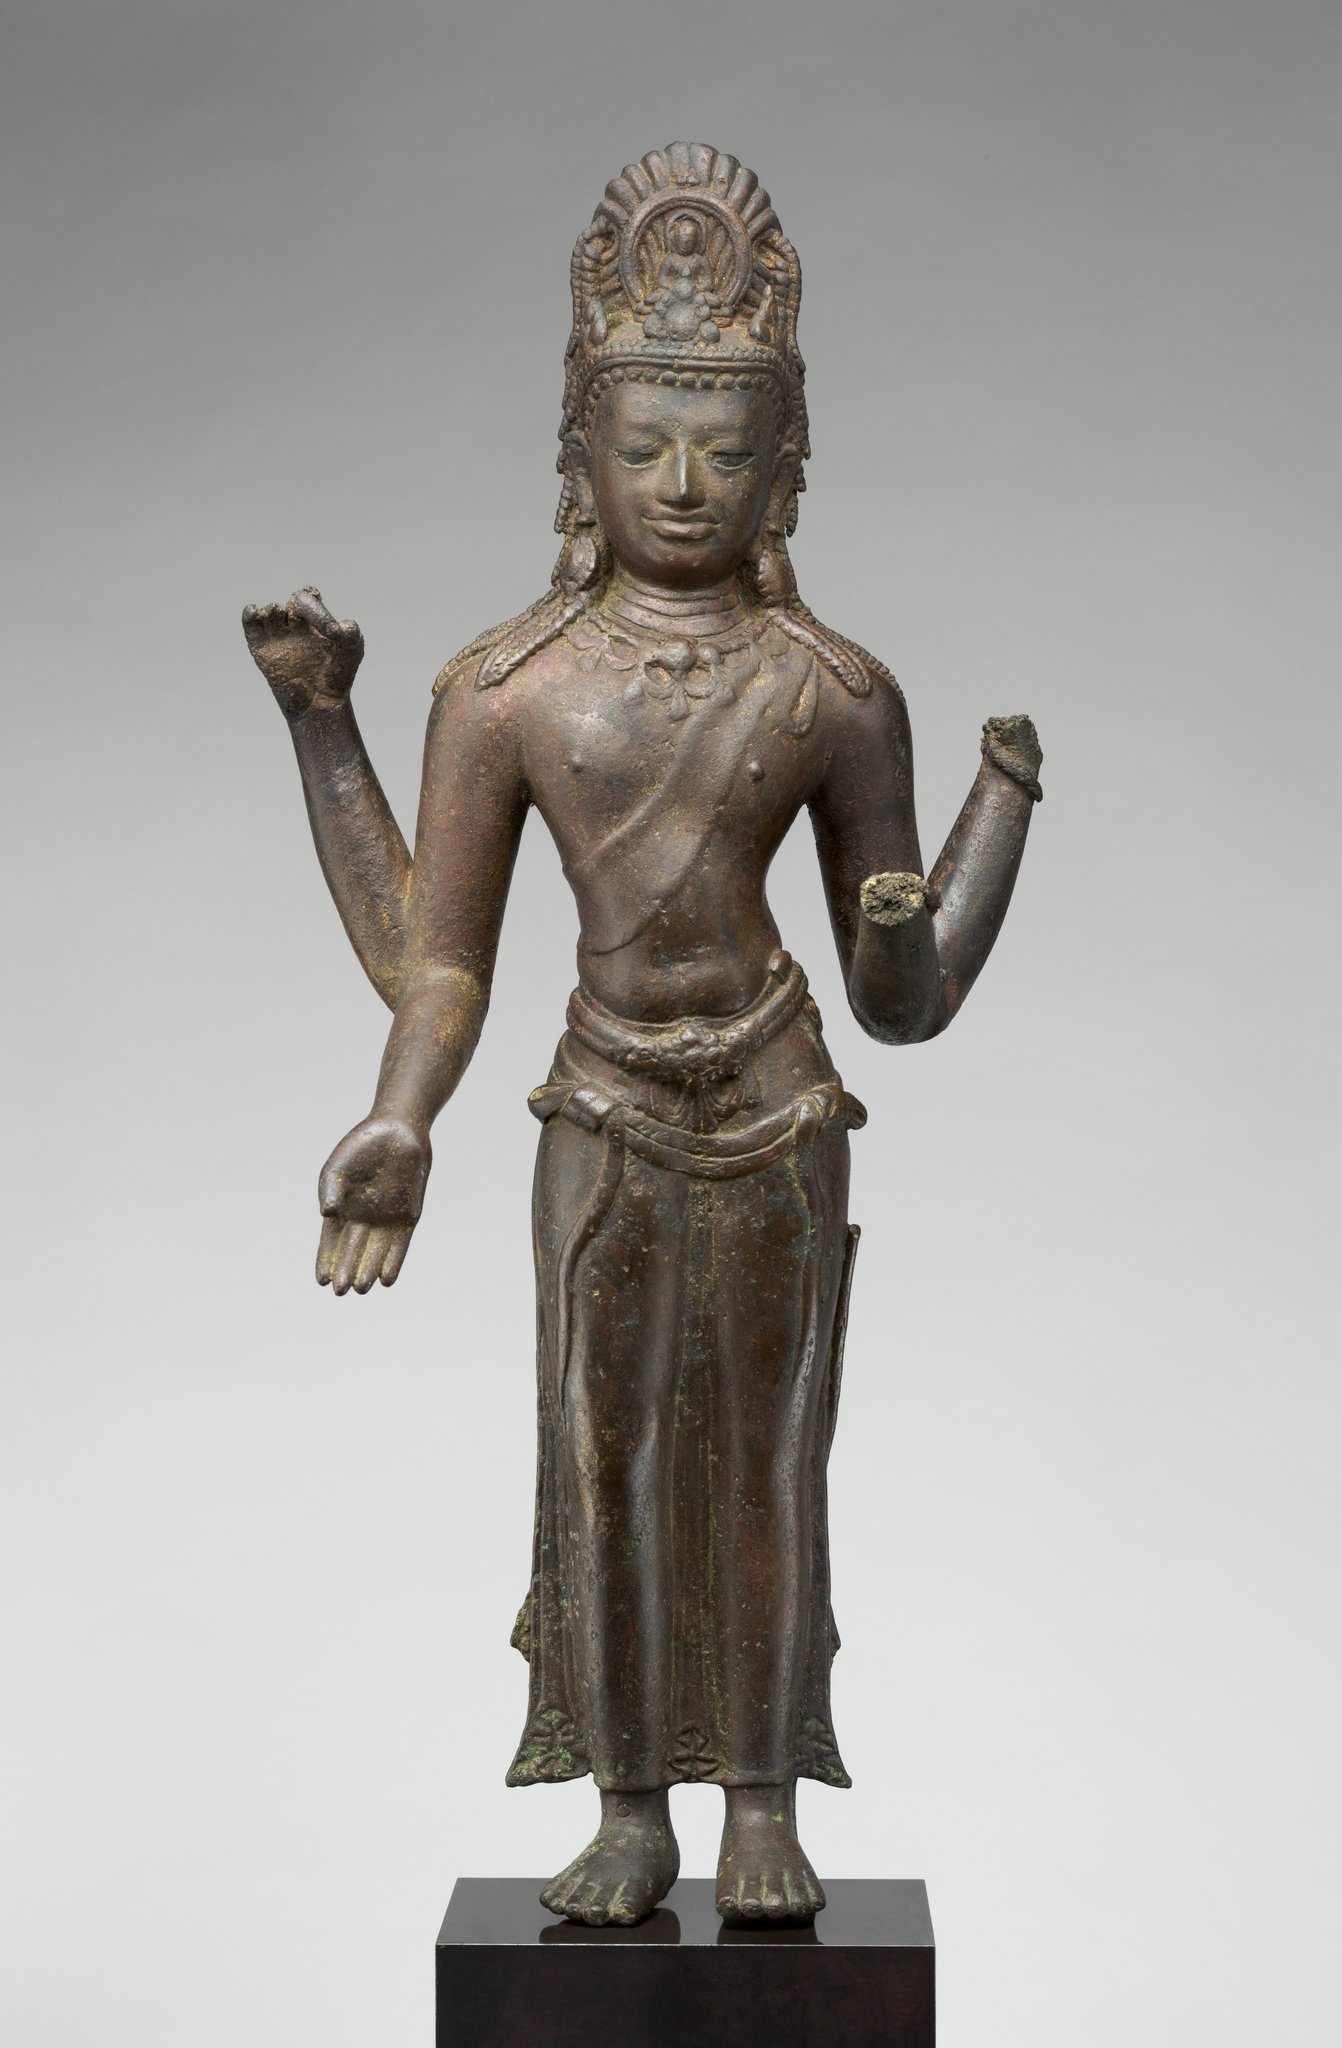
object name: figure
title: Bodhisattva Avalokiteshvara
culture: thai or sumatran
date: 701-833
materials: copper alloy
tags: buddhism,avalokiteshvara,bodhisattvas